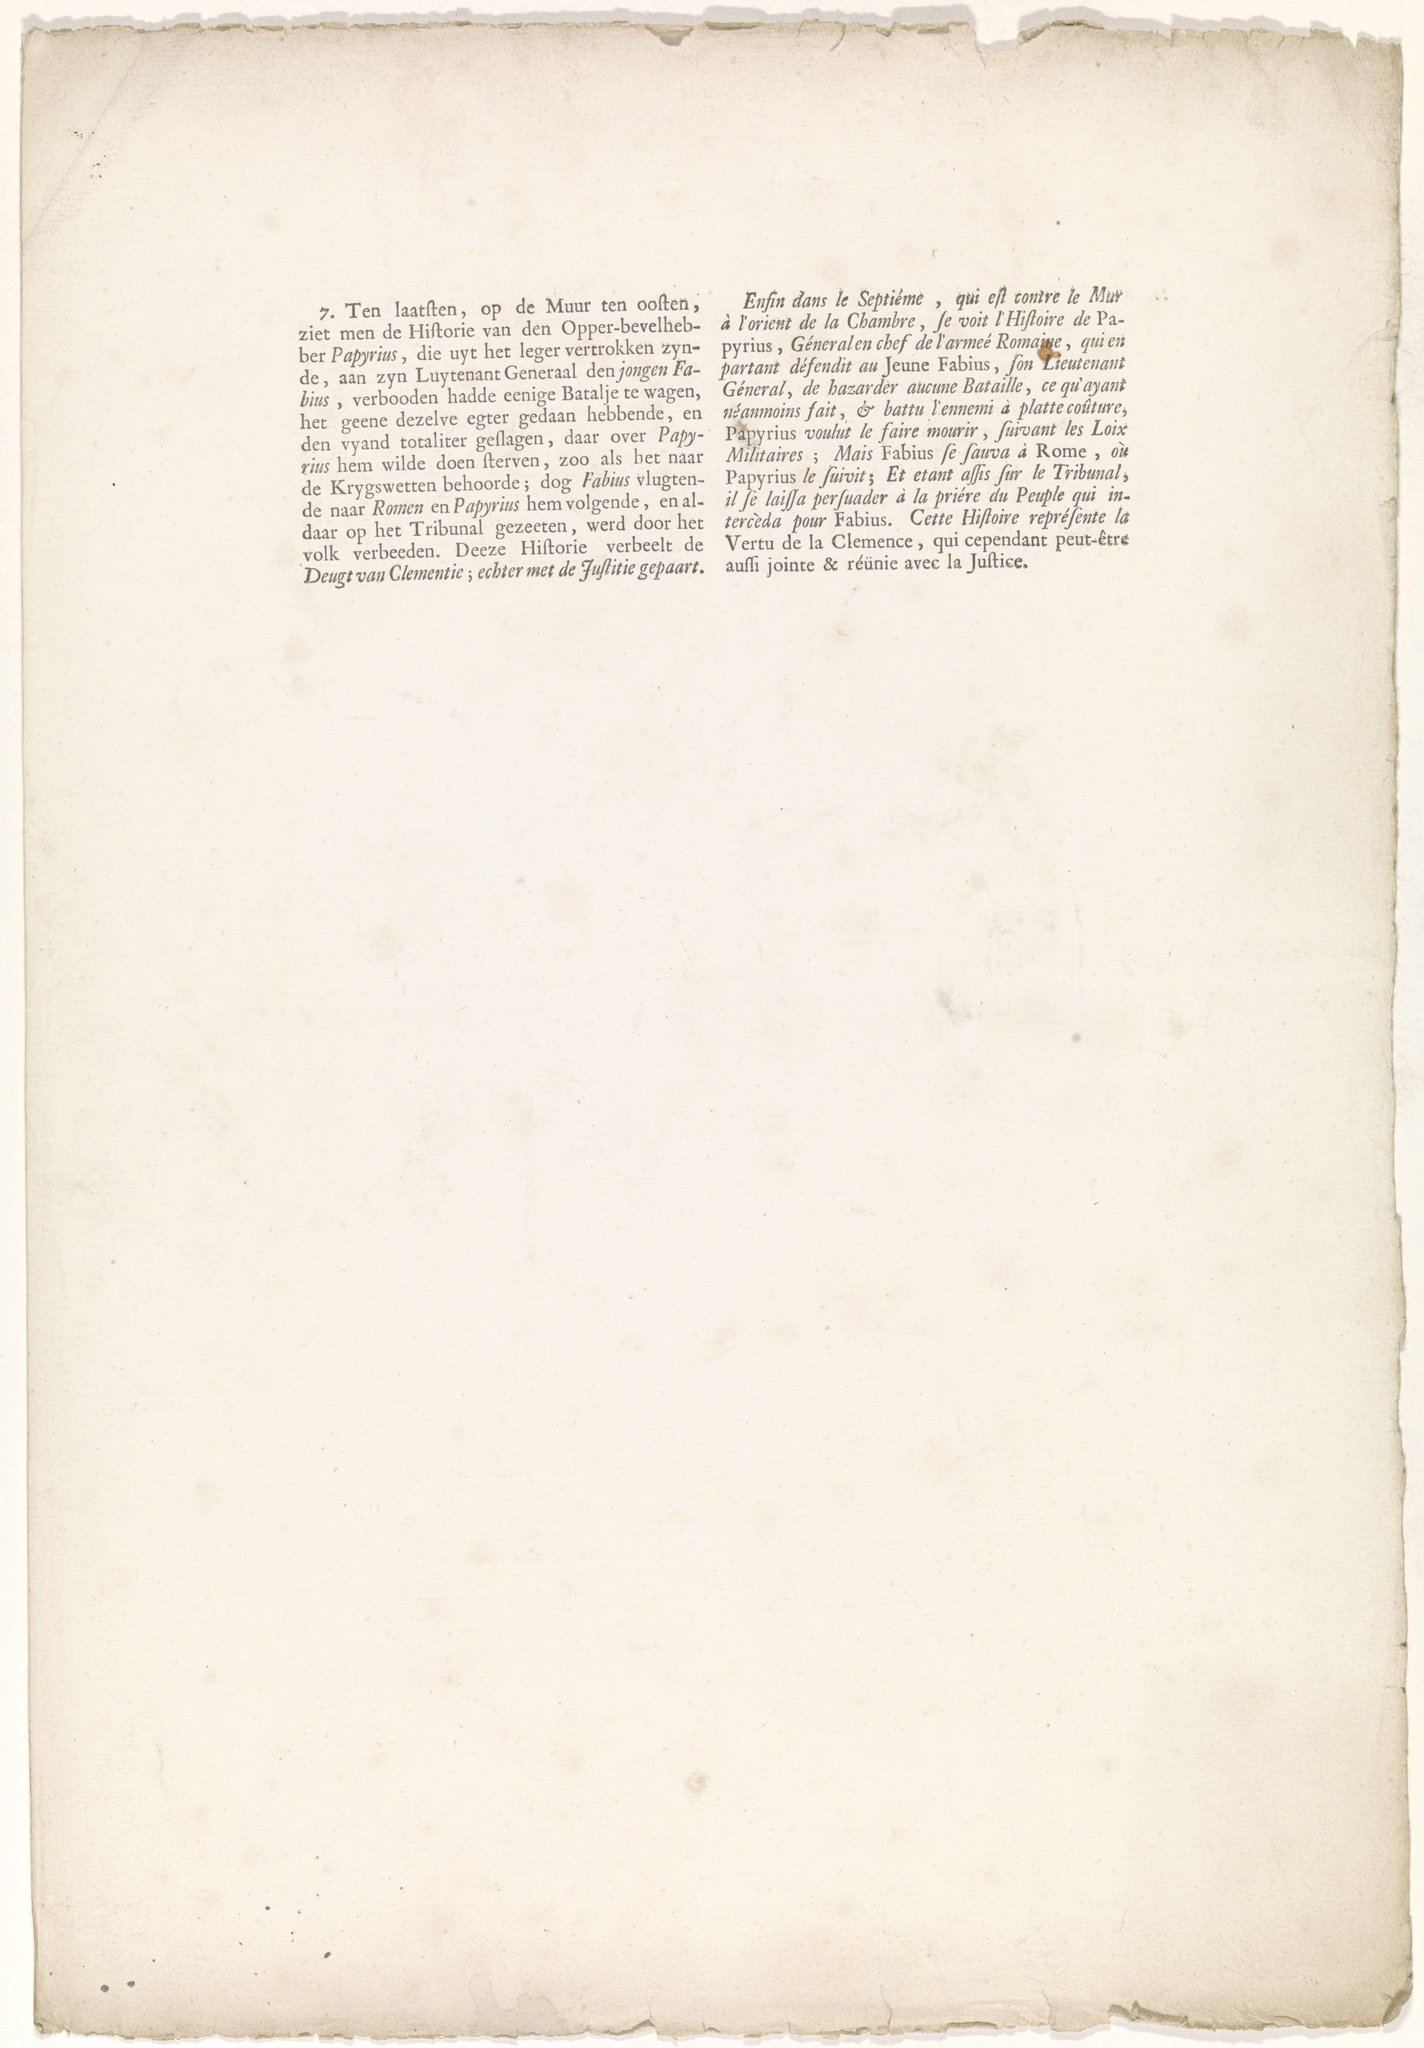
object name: text sheet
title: Verklarende tekst bij de prent naar Lairesse's schilderij Lucius Papirius vergeeft Fabius Maximus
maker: nicolaas verkolje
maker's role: draughtsman, painter, print maker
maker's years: 1673-1746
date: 1737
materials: paper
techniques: letterpress printing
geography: amsterdam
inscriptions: collector's mark: Lugt 2228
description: Verklarende tekst in het Nederlands en Frans bij de prent van Pieter Tanjé naar Gerard de Lairesse's schilderij 'Lucius Papirius vergeeft Fabius Maximus', in de Raadkamer van het Hof van Justitie van Holland, Zeeland en West-Friesland in het Binnenhof te Den Haag.